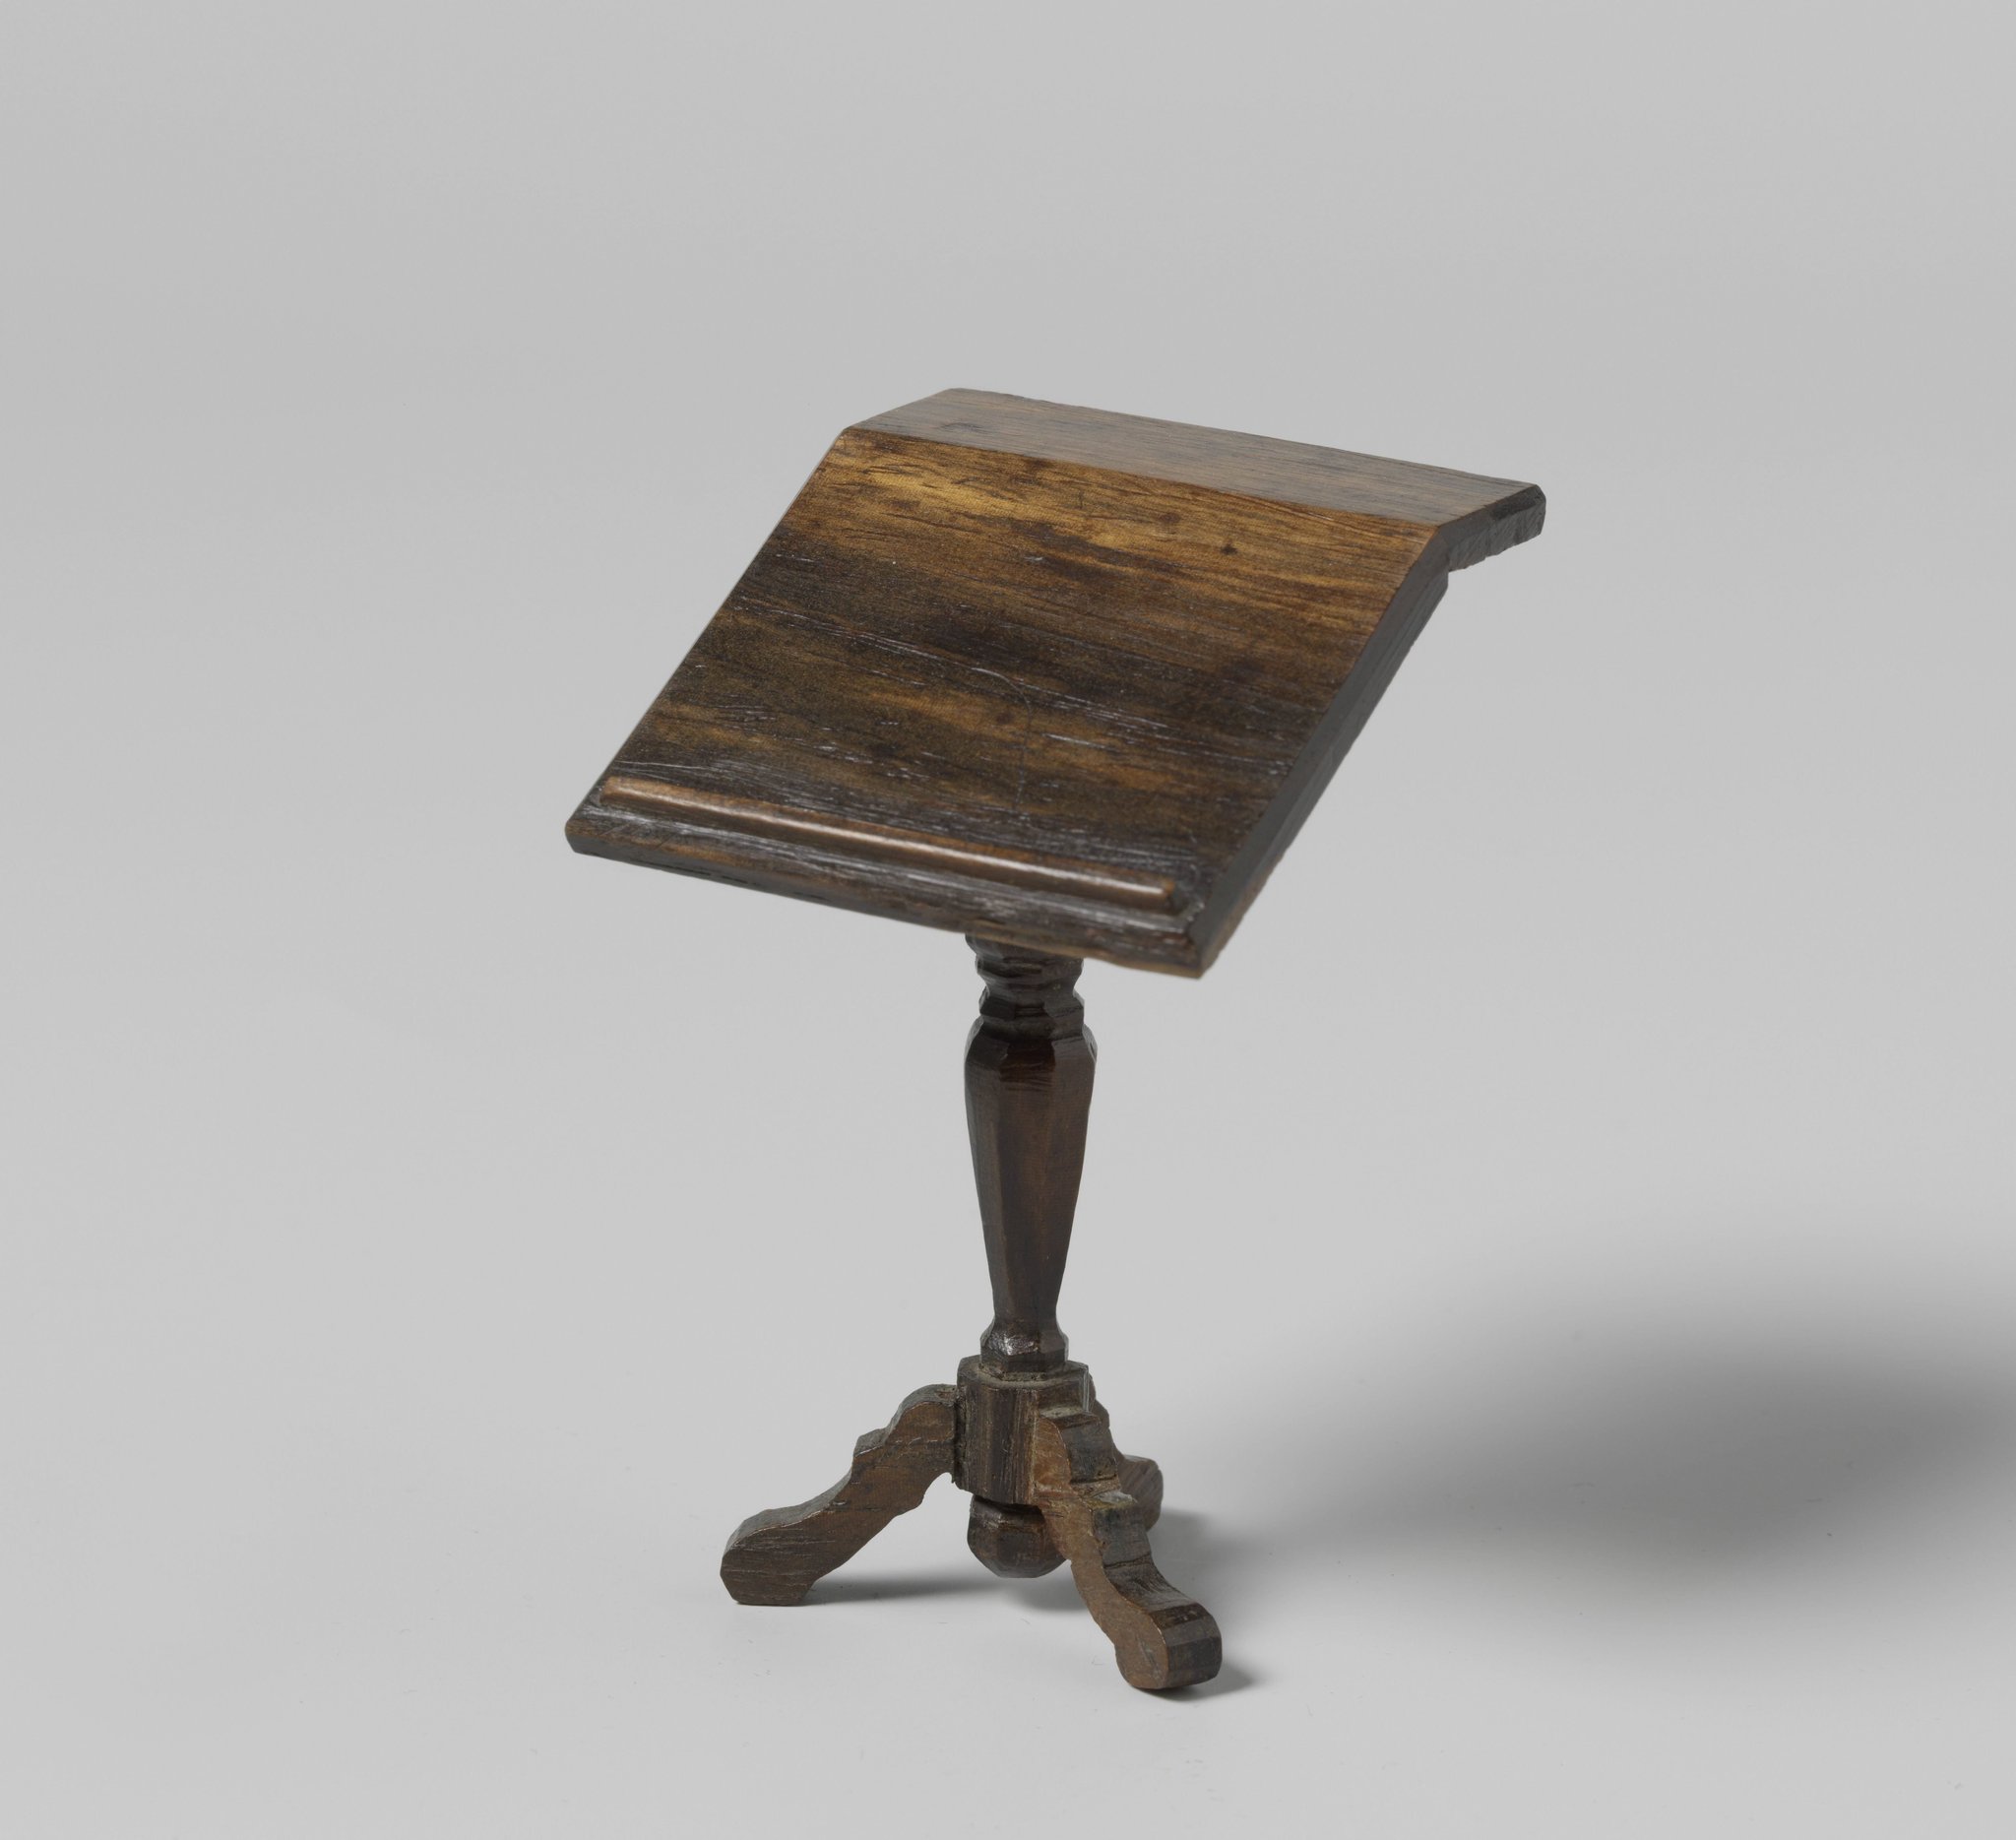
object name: lectern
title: Lessenaar met rechthoekig blad op achthoekige, balustervormige stam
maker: Anonymous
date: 1700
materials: wood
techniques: tropisch hardhout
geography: amsterdam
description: Lessenaar van hardhout met een rechthoekig glad blad met een opstaande rand. De balustervormige stam is achthoekig en steunt op een geprofileerde, gebogen driepoot.